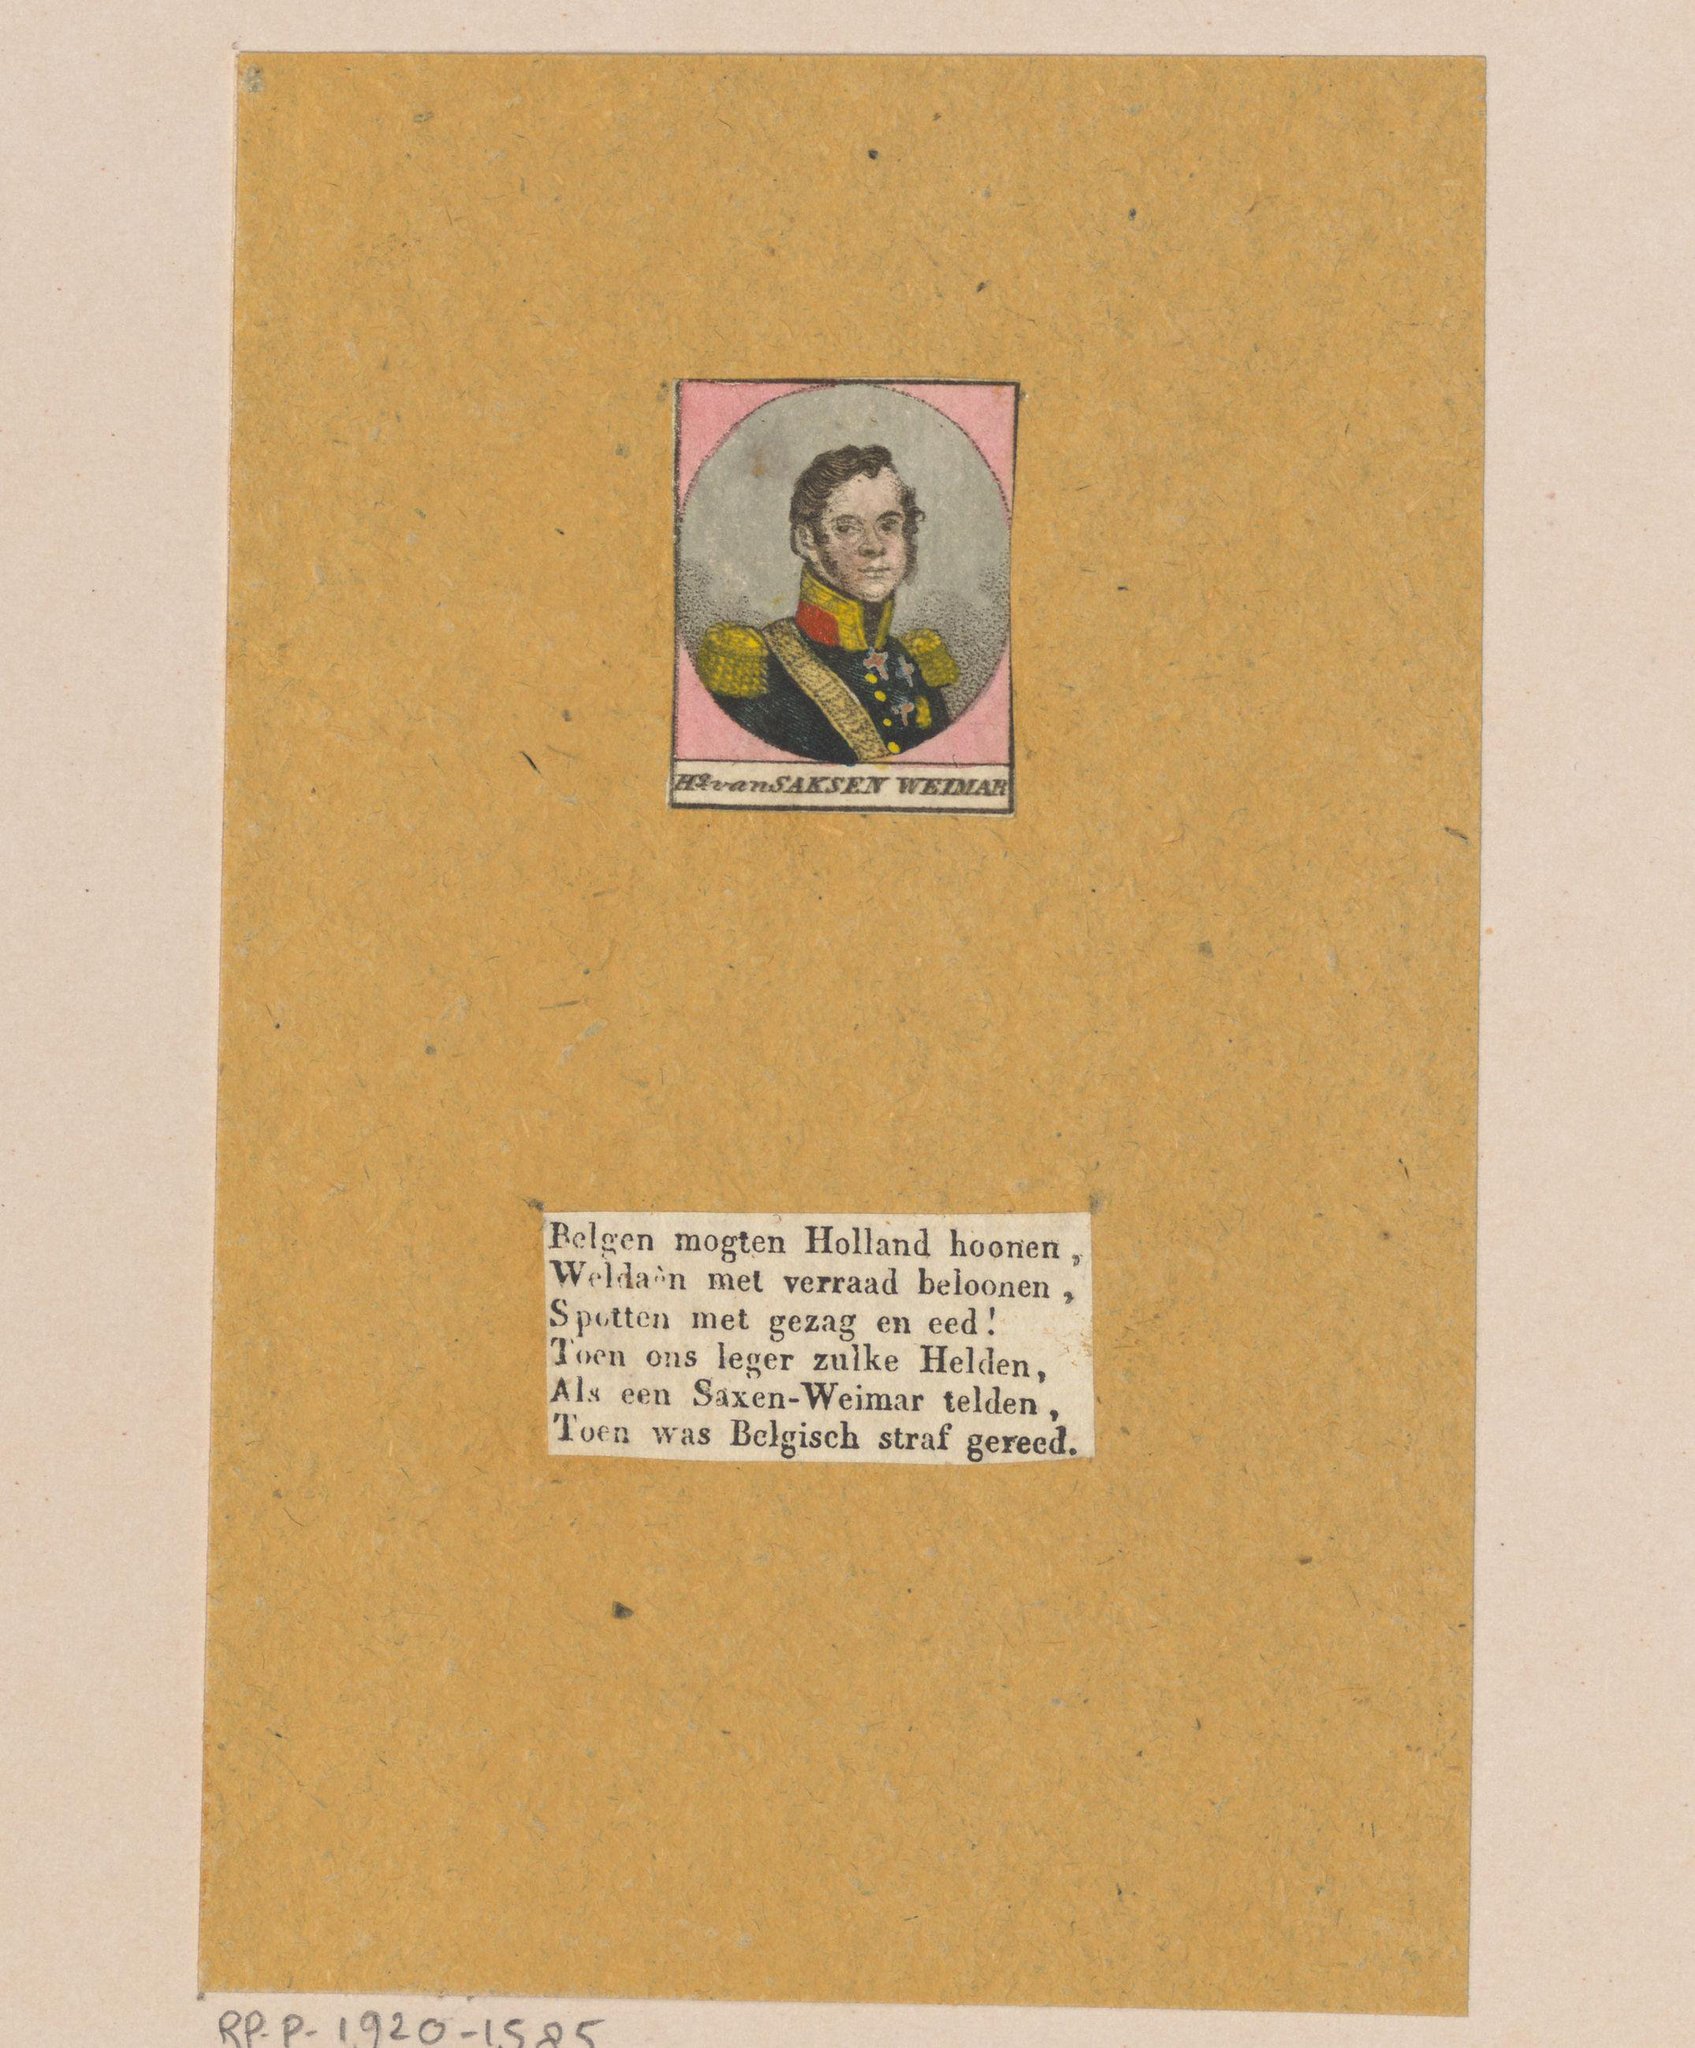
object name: print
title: Portret van Karel Bernard, hertog van Saksen-Weimar-Eisenach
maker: Anonymous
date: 1830-1860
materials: paper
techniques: etching, hand coloring, letterpress printing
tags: karel bernhard (hertog van saksen-weimar-eisenach), historical persons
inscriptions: collector's mark: Lugt 2228